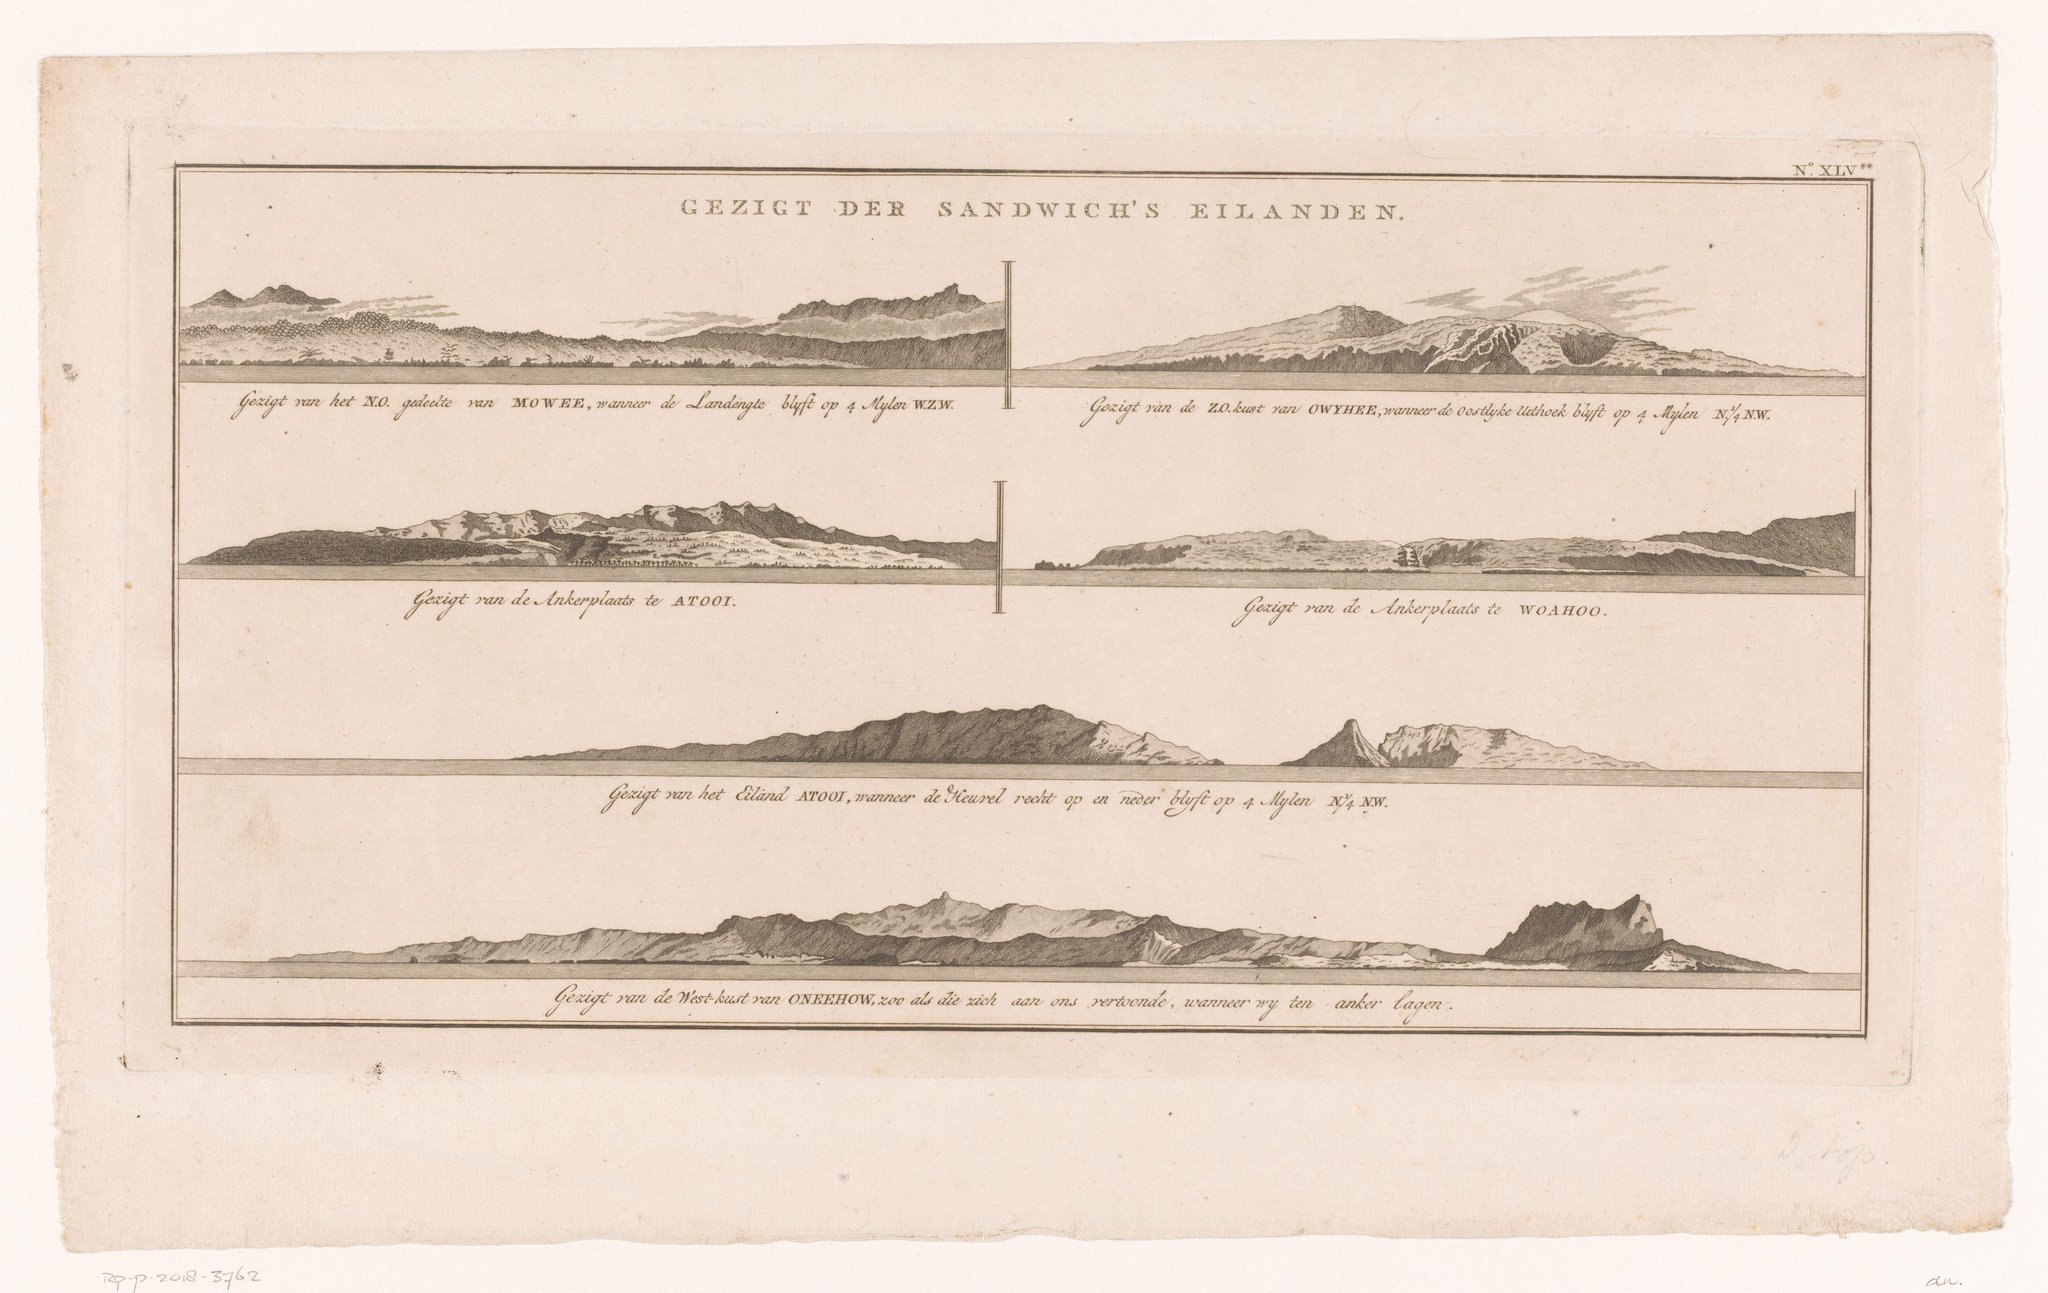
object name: print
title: Zes gezichten op de kusten van de Hawaïaanse eilanden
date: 1802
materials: paper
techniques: etching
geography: amsterdam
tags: coast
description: Prent uit: Cook, James. Reize rondom de Waereld (...) met kaarten en plaaten. [Vertaald uit het Engels door] Jan David Pasteur. Leiden: Honkoop, Amsterdam: Allart, Den Haag: Van Cleef, 1802, dl. 11, p. 388.